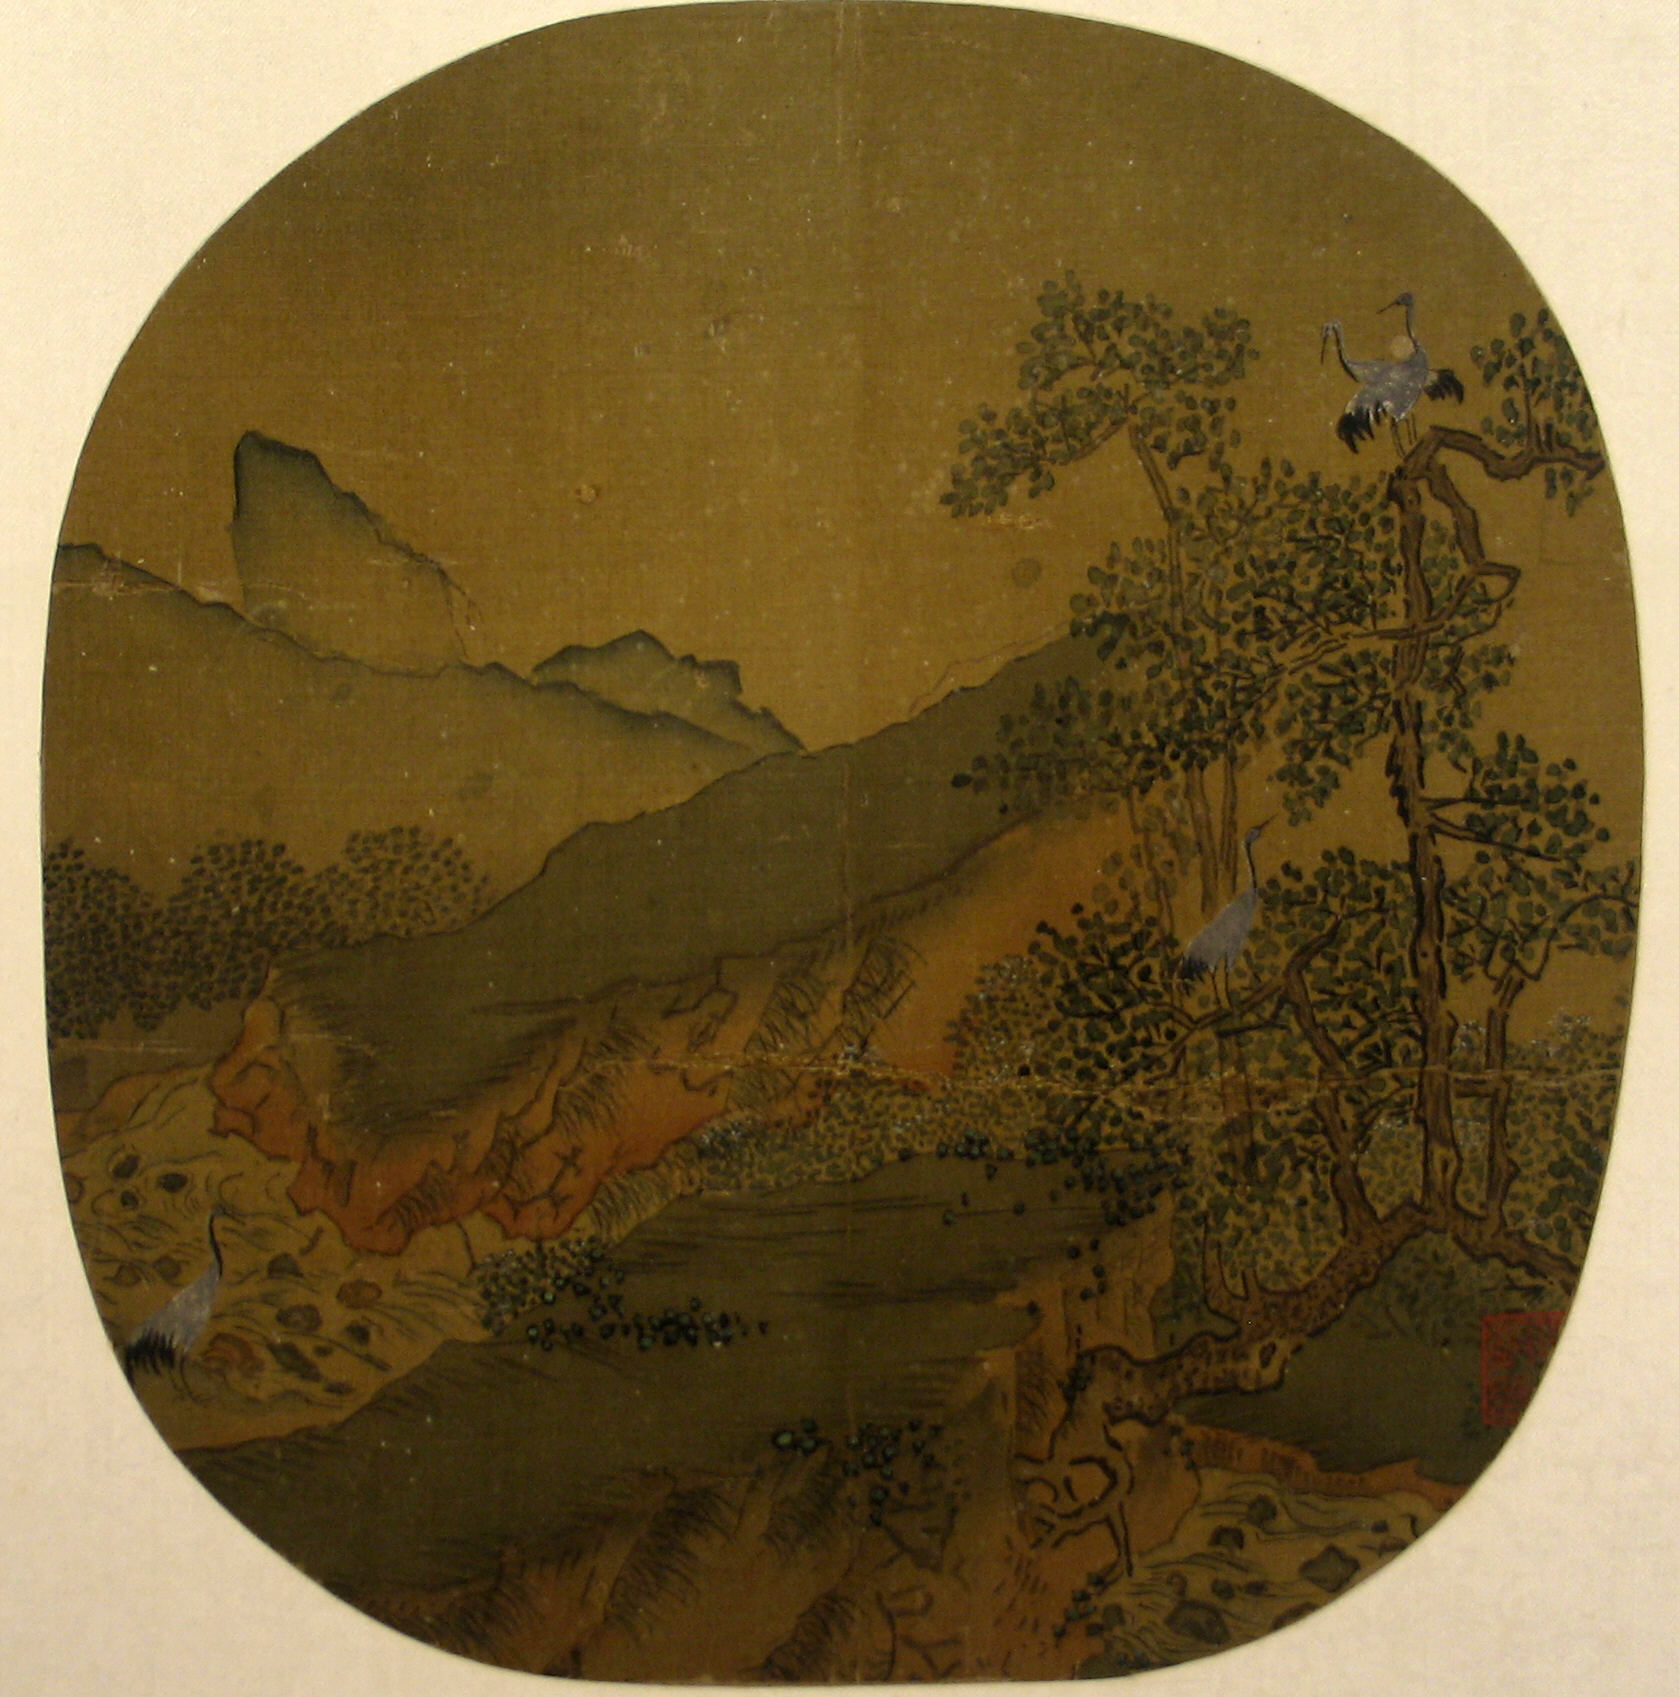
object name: fan mounted a an album leaf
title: Mountain Landscape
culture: chinese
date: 1368-1911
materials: ink, silk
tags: cranes,mountains,landscapes